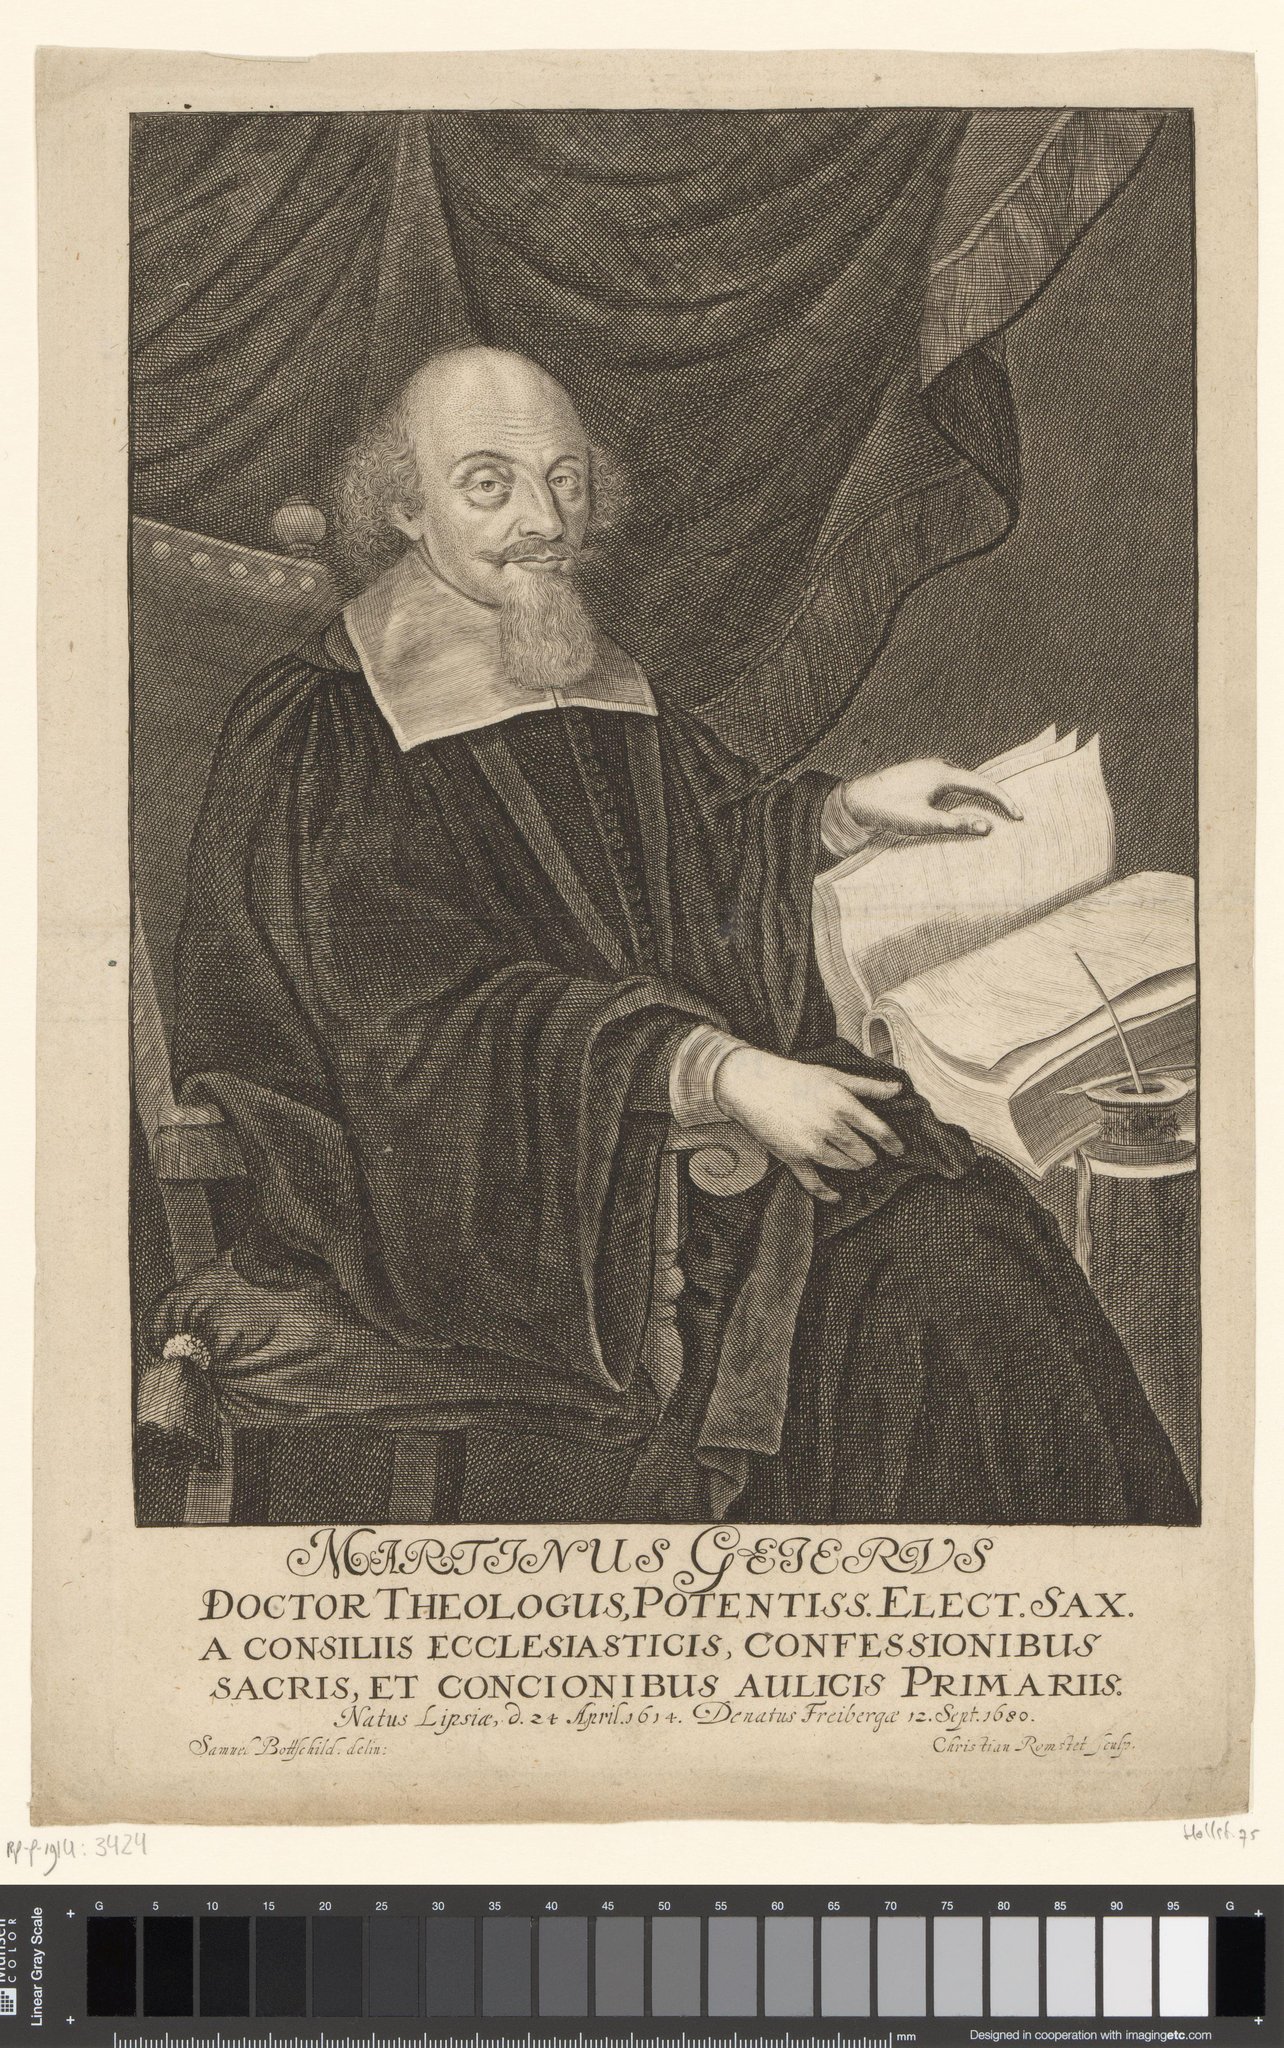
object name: print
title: Portret van Martin Geier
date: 1680-1721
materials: paper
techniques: engraving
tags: historical persons, writing accessories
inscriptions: collector's mark: Lugt 2228